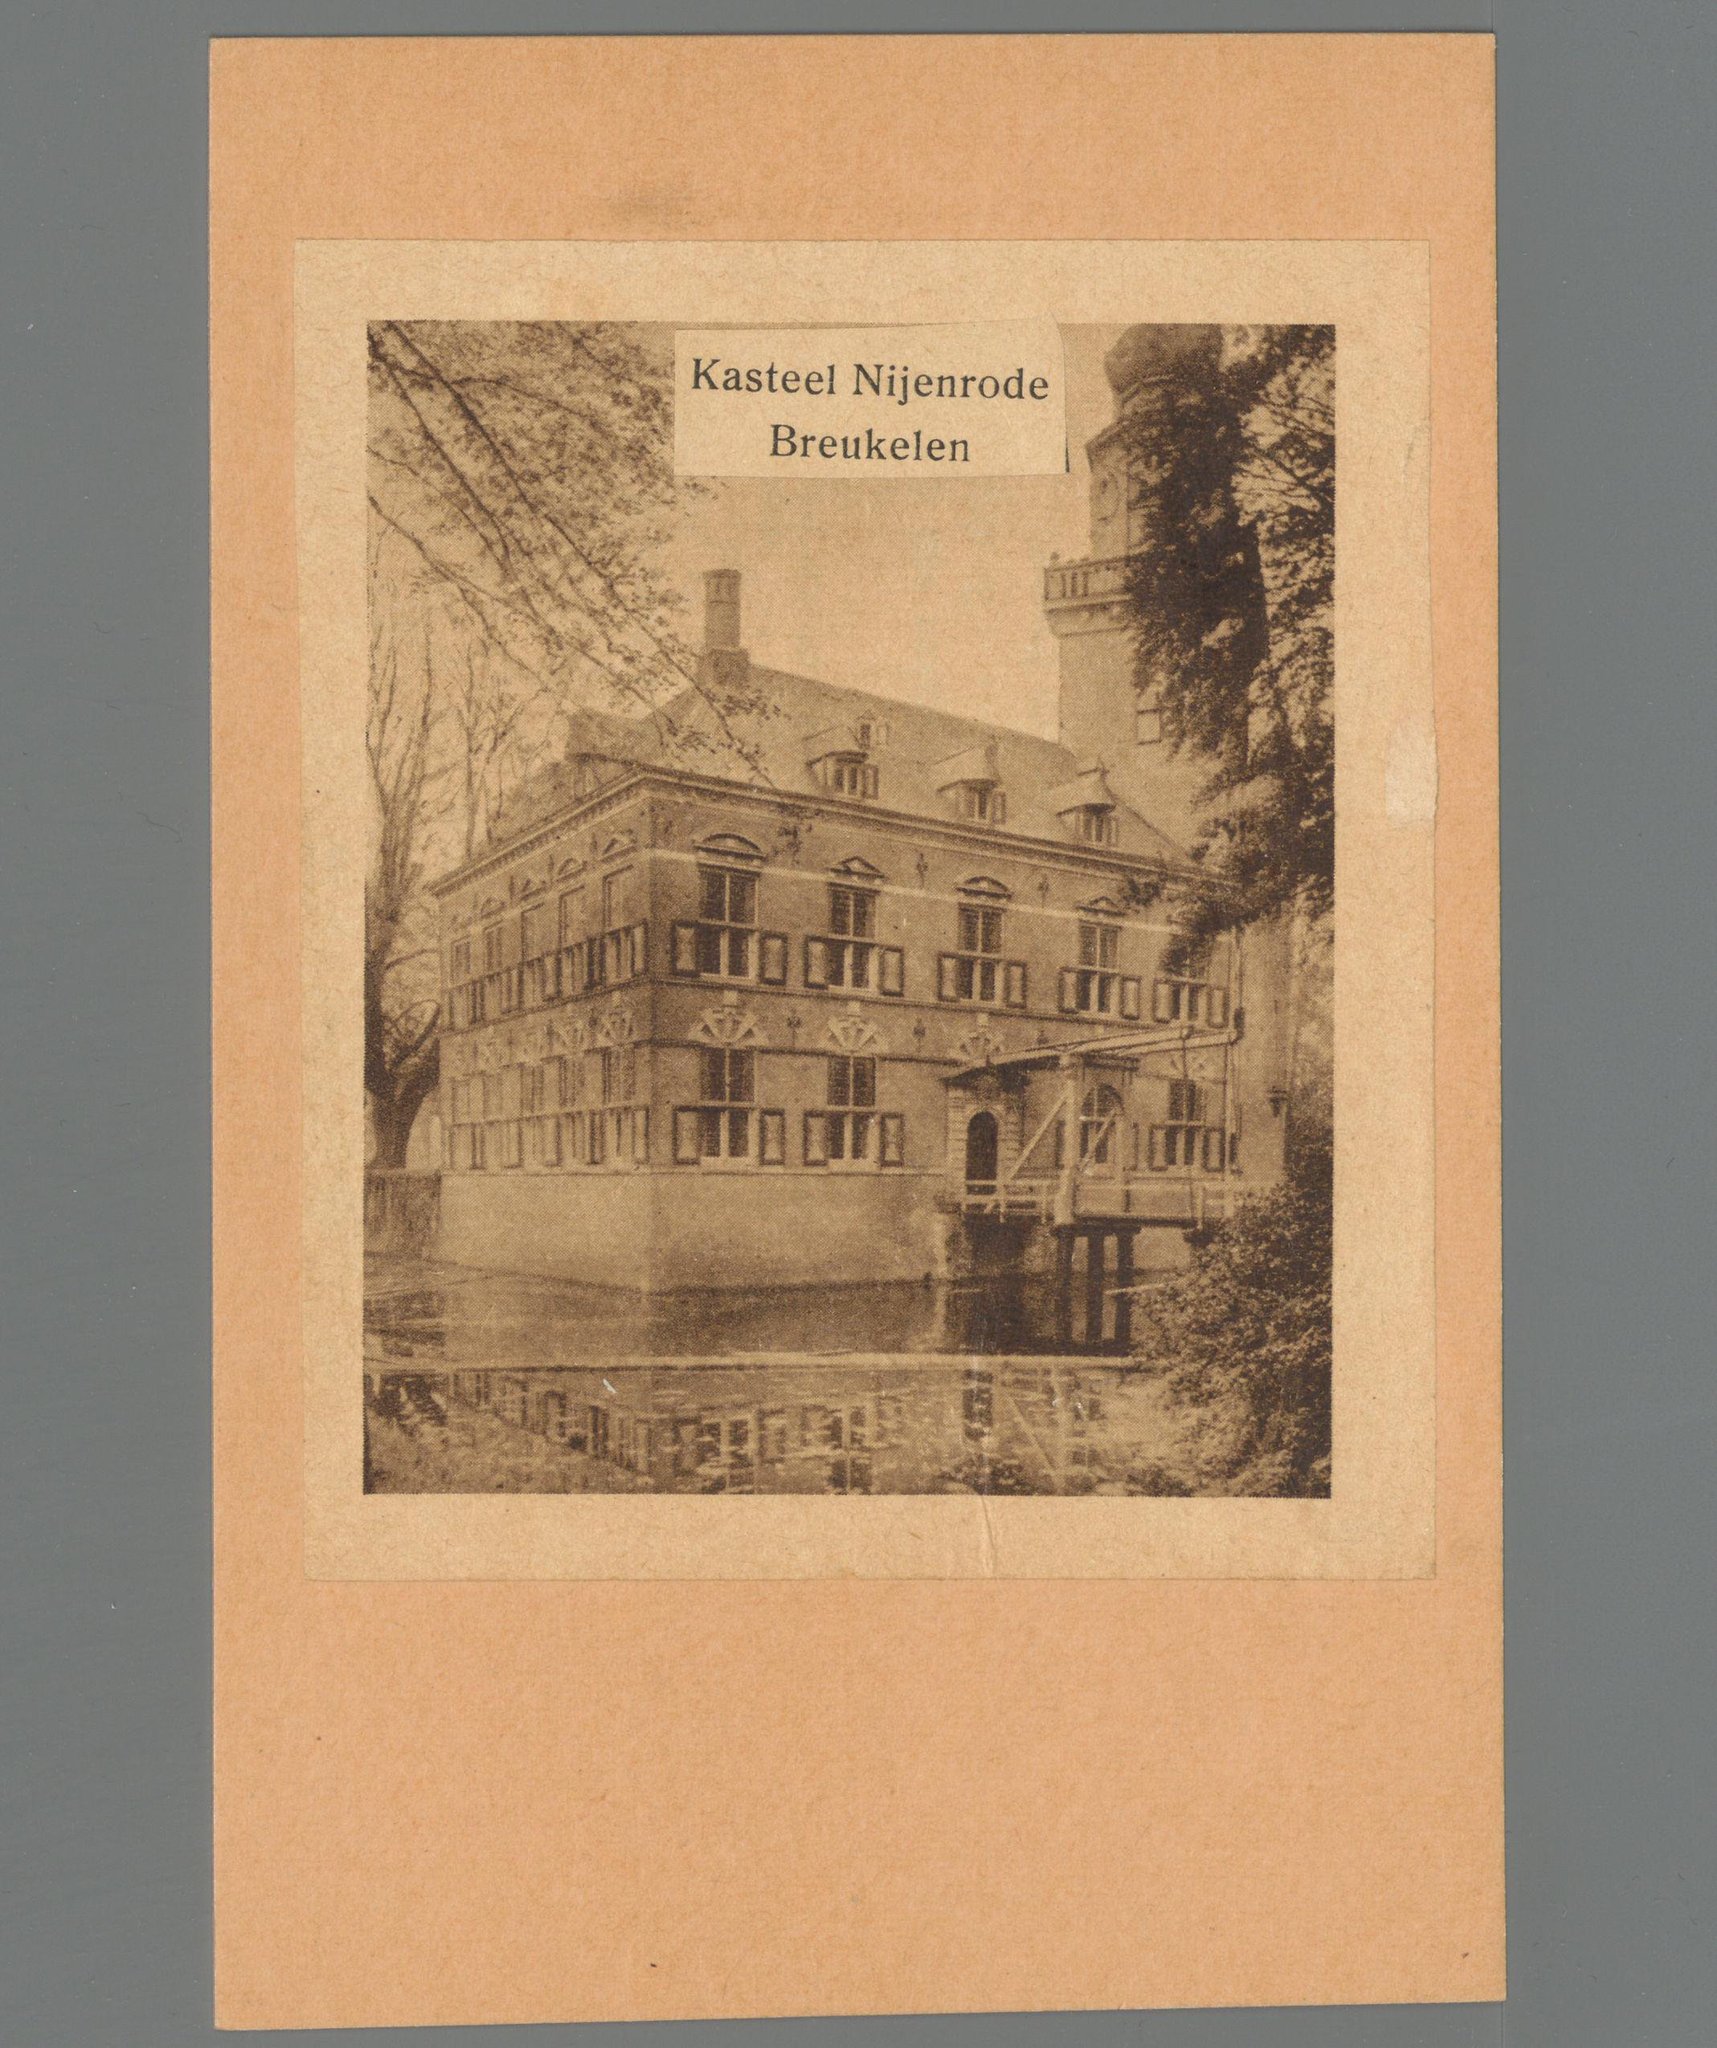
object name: ansichtkaart, prentbriefkaart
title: Kasteel Nijenrode. Breukelen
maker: Anonymous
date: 1895-1930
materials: cardboard, paper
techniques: rotogravure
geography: breukelen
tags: castle, pond